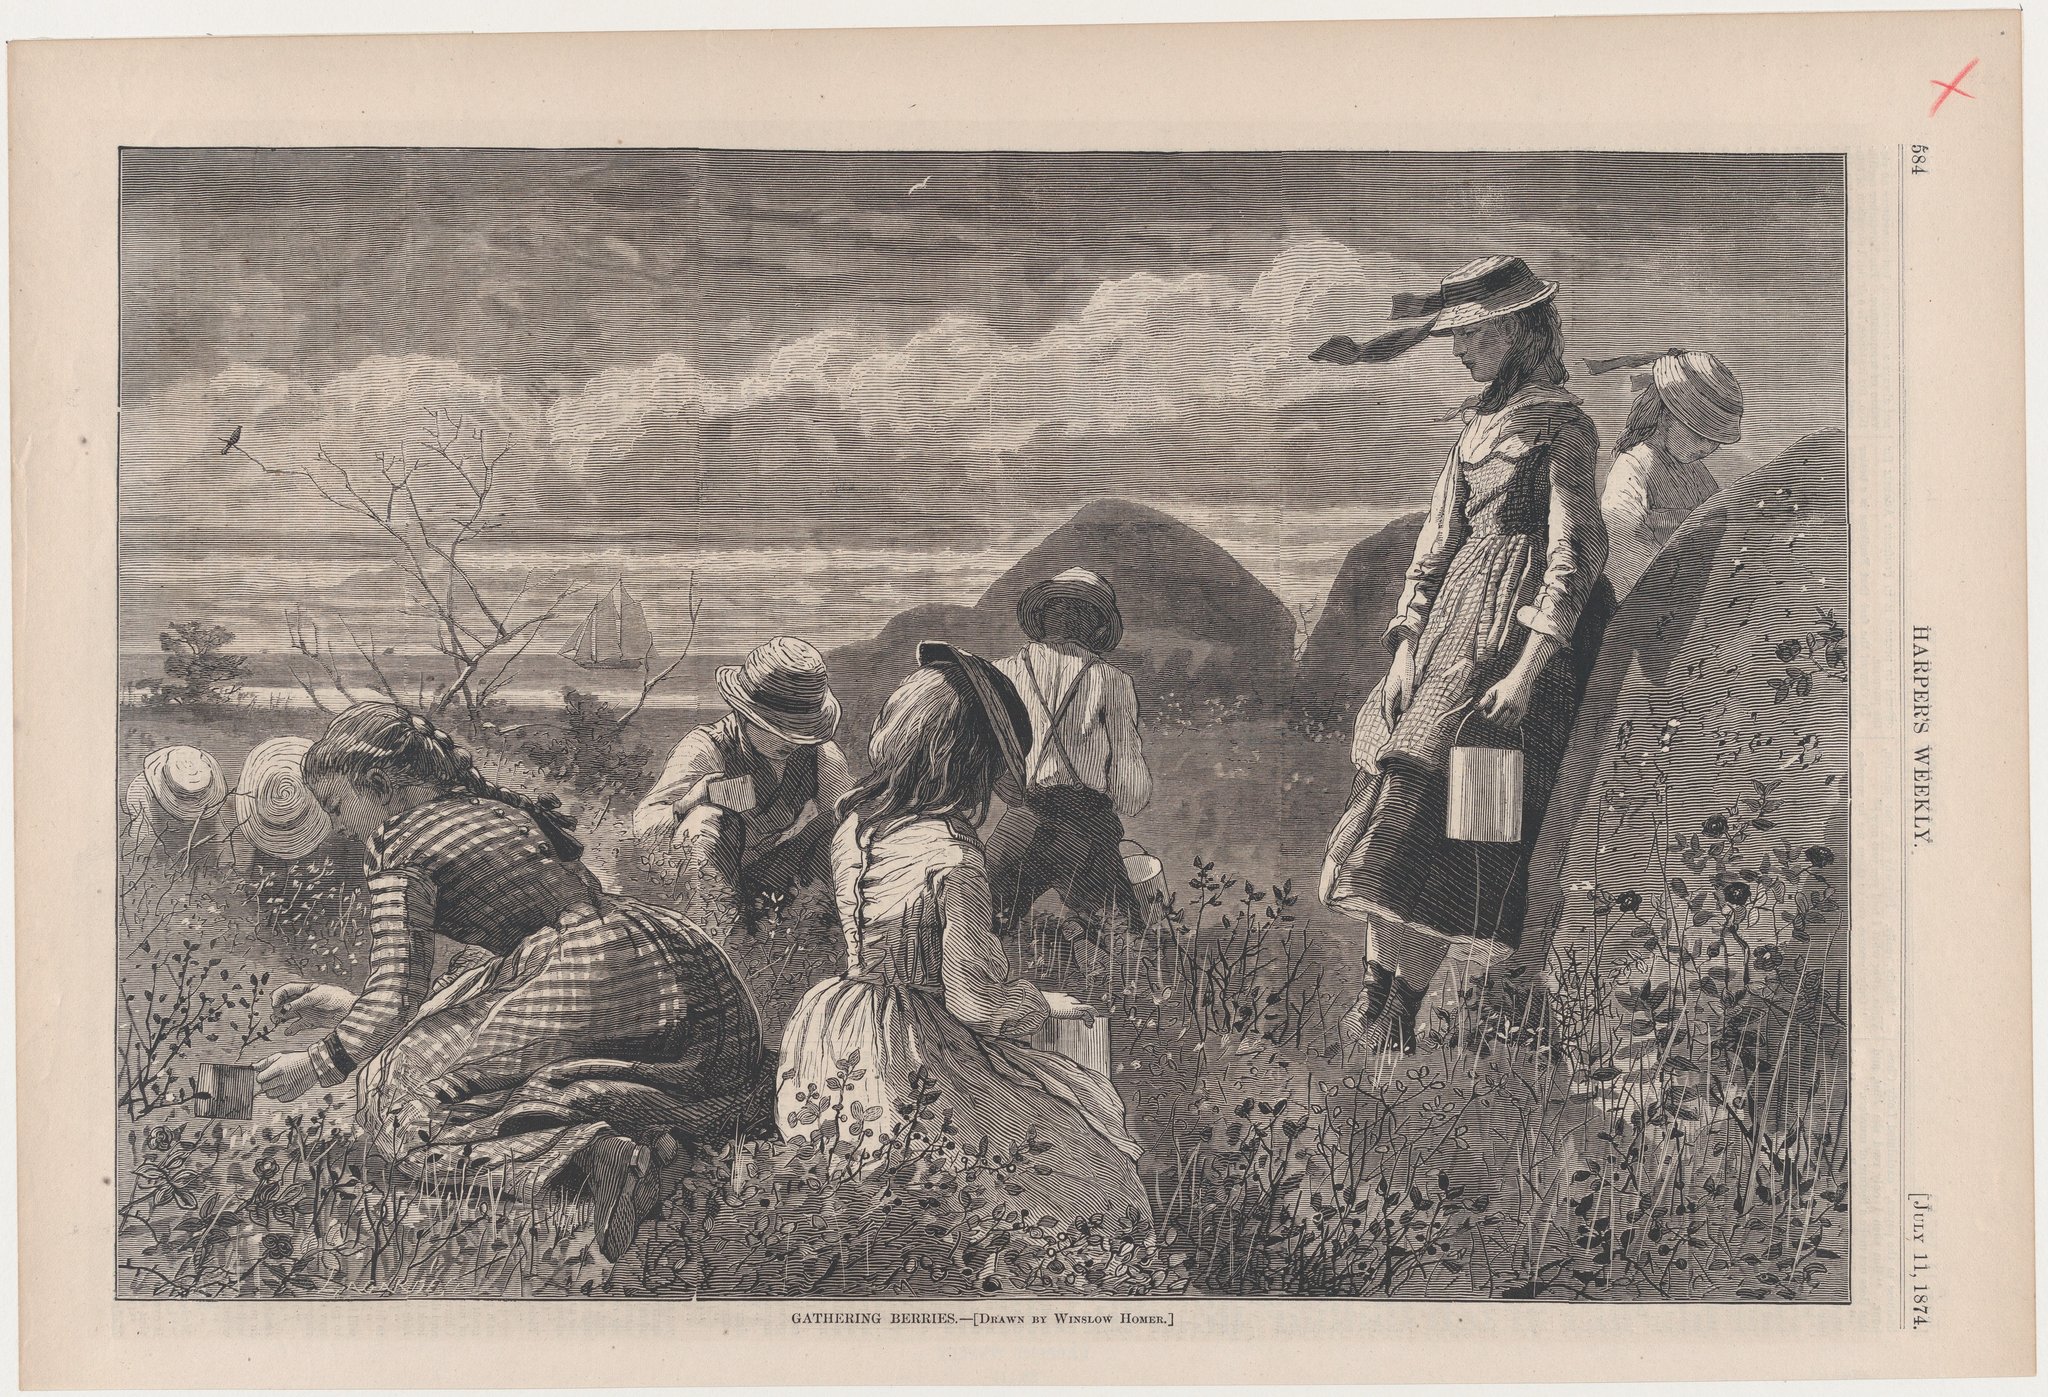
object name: print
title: Gathering Berries (from "Harper's Weekly," Vol. XVIII)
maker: winslow homer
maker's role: artist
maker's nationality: american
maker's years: 1836-1910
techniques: engraving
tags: fruit,girls,women,working,boats